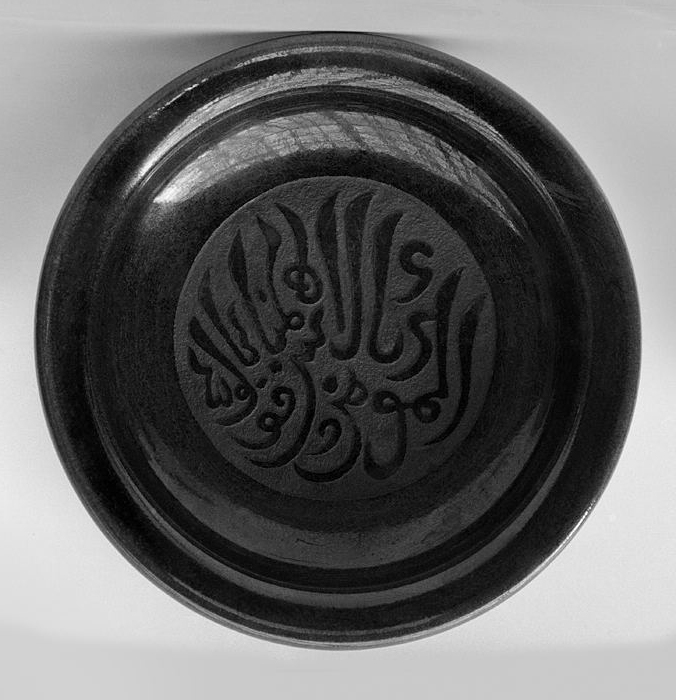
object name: bowl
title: Bulb Bowl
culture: chinese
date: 1723-1735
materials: porcelain